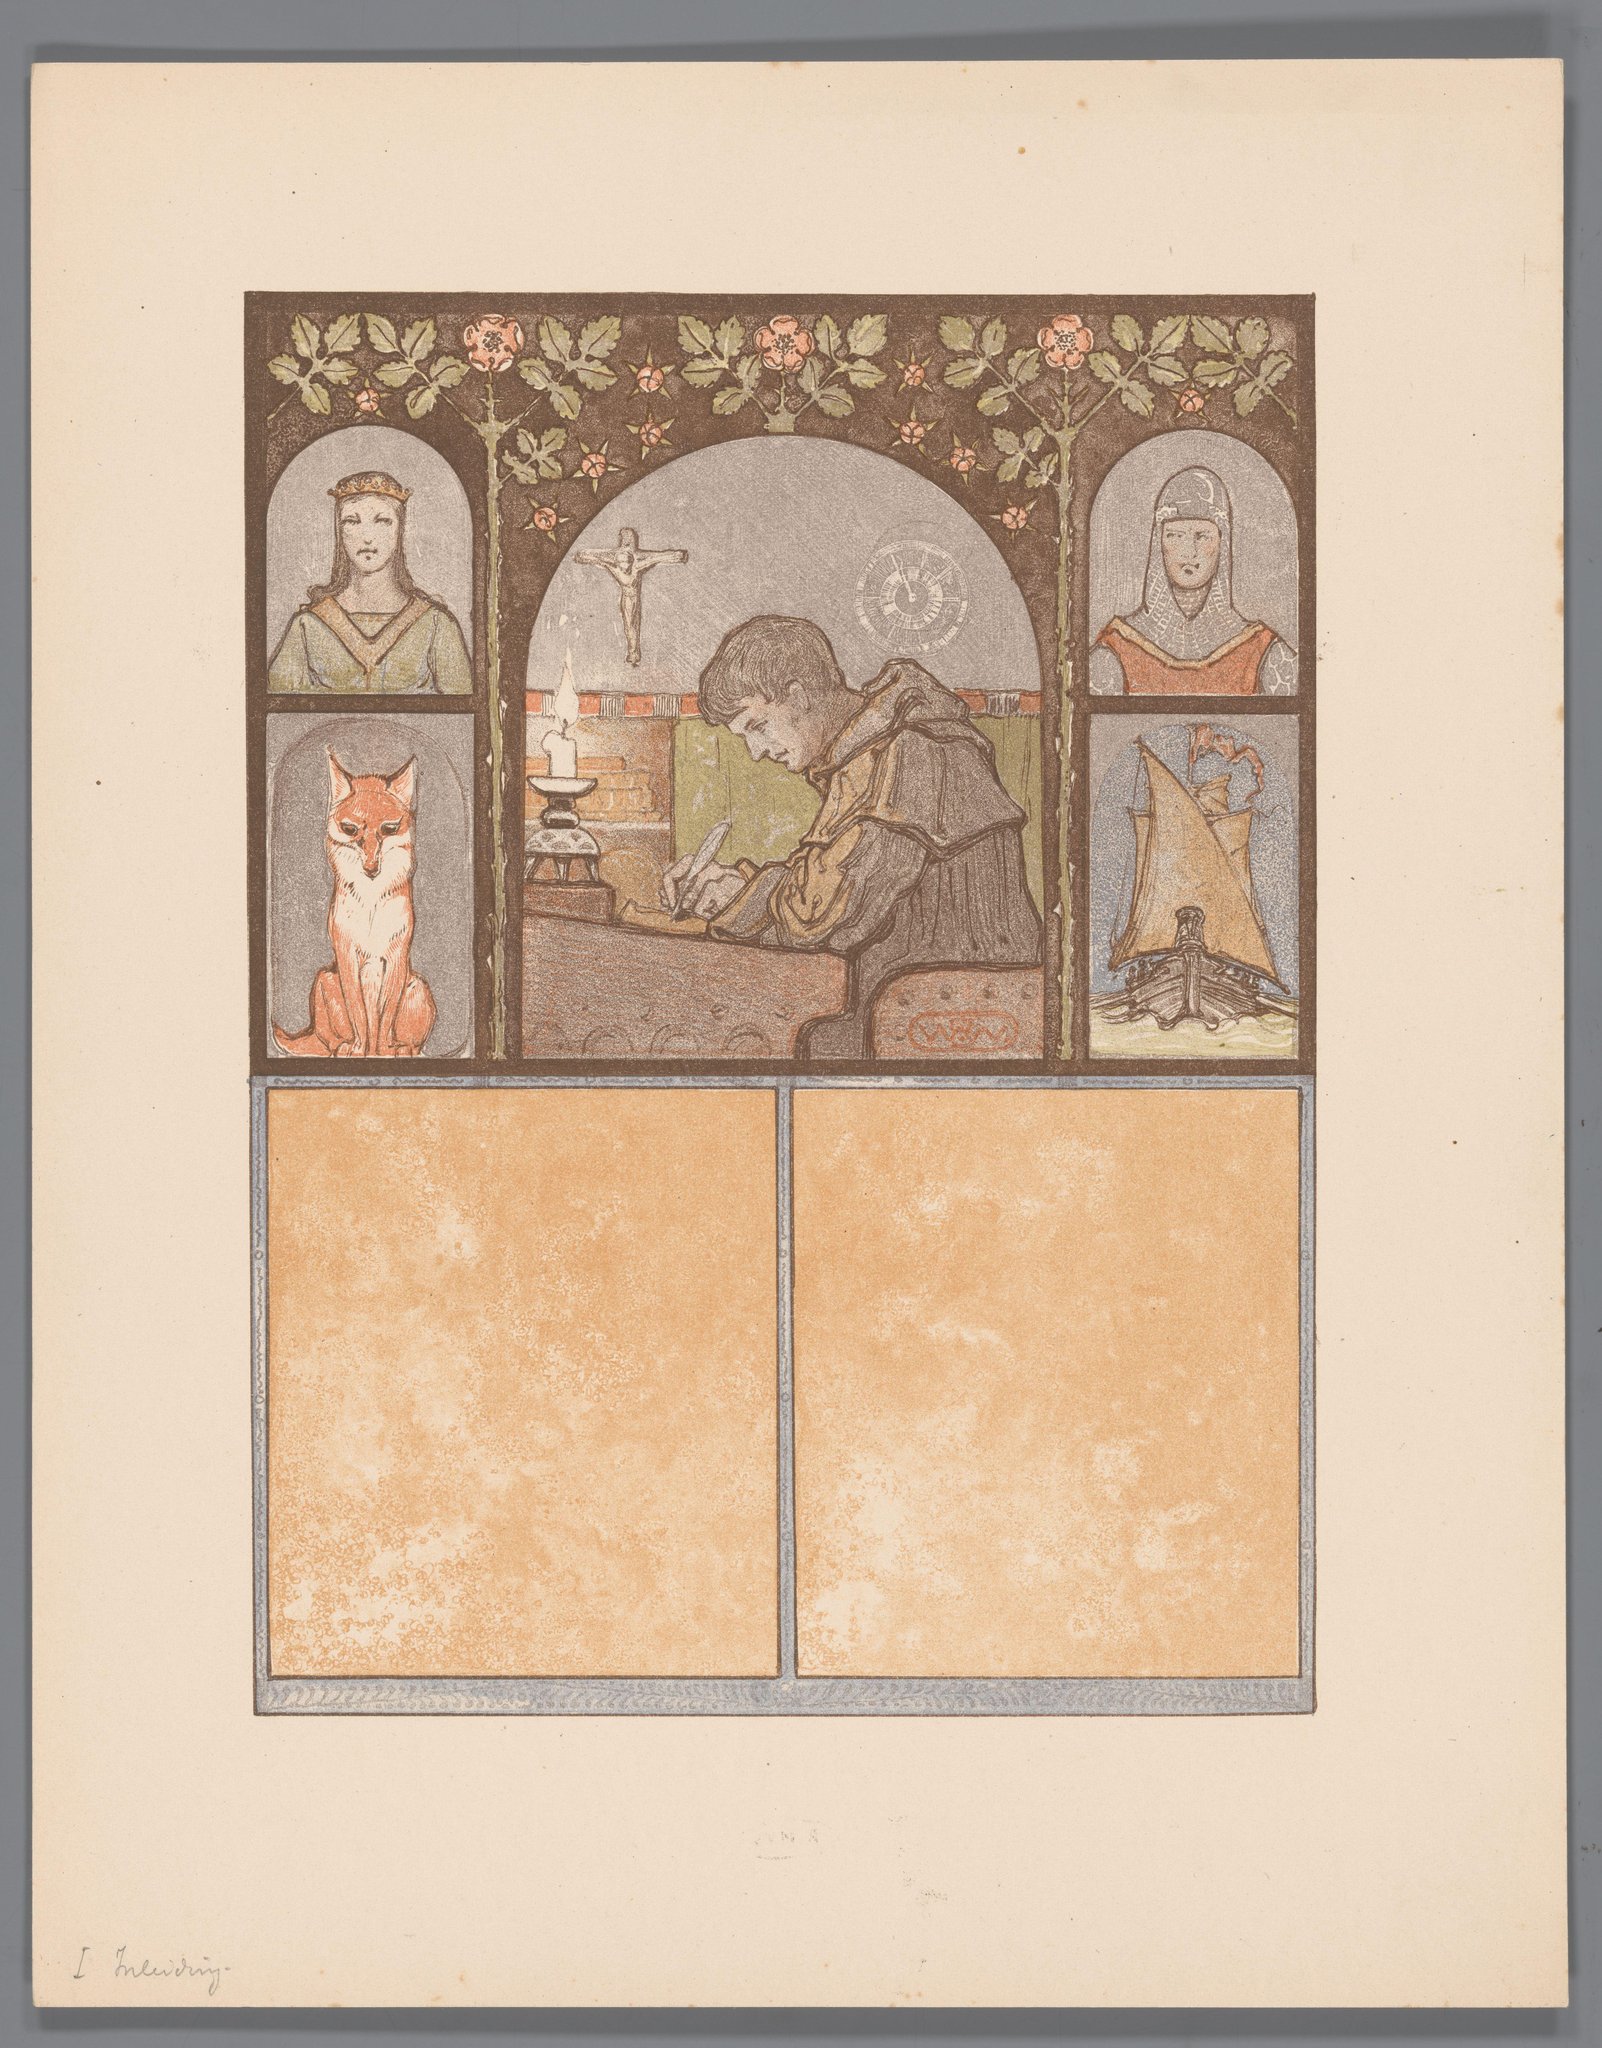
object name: boekillustratie ontwerp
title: Schrijvende monnik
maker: bernard willem wierink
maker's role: draughtsman, print maker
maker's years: 1856-1939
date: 1910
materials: paper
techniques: lithograph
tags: fable of reynard the fox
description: Ontwerp voor: Streuvels, Stijn (Frank Lateur). Reinaert de Vos naar verschillende uitgaven van het middeleeuwsche epos. Amsterdam: L.J. Veen, 1910.